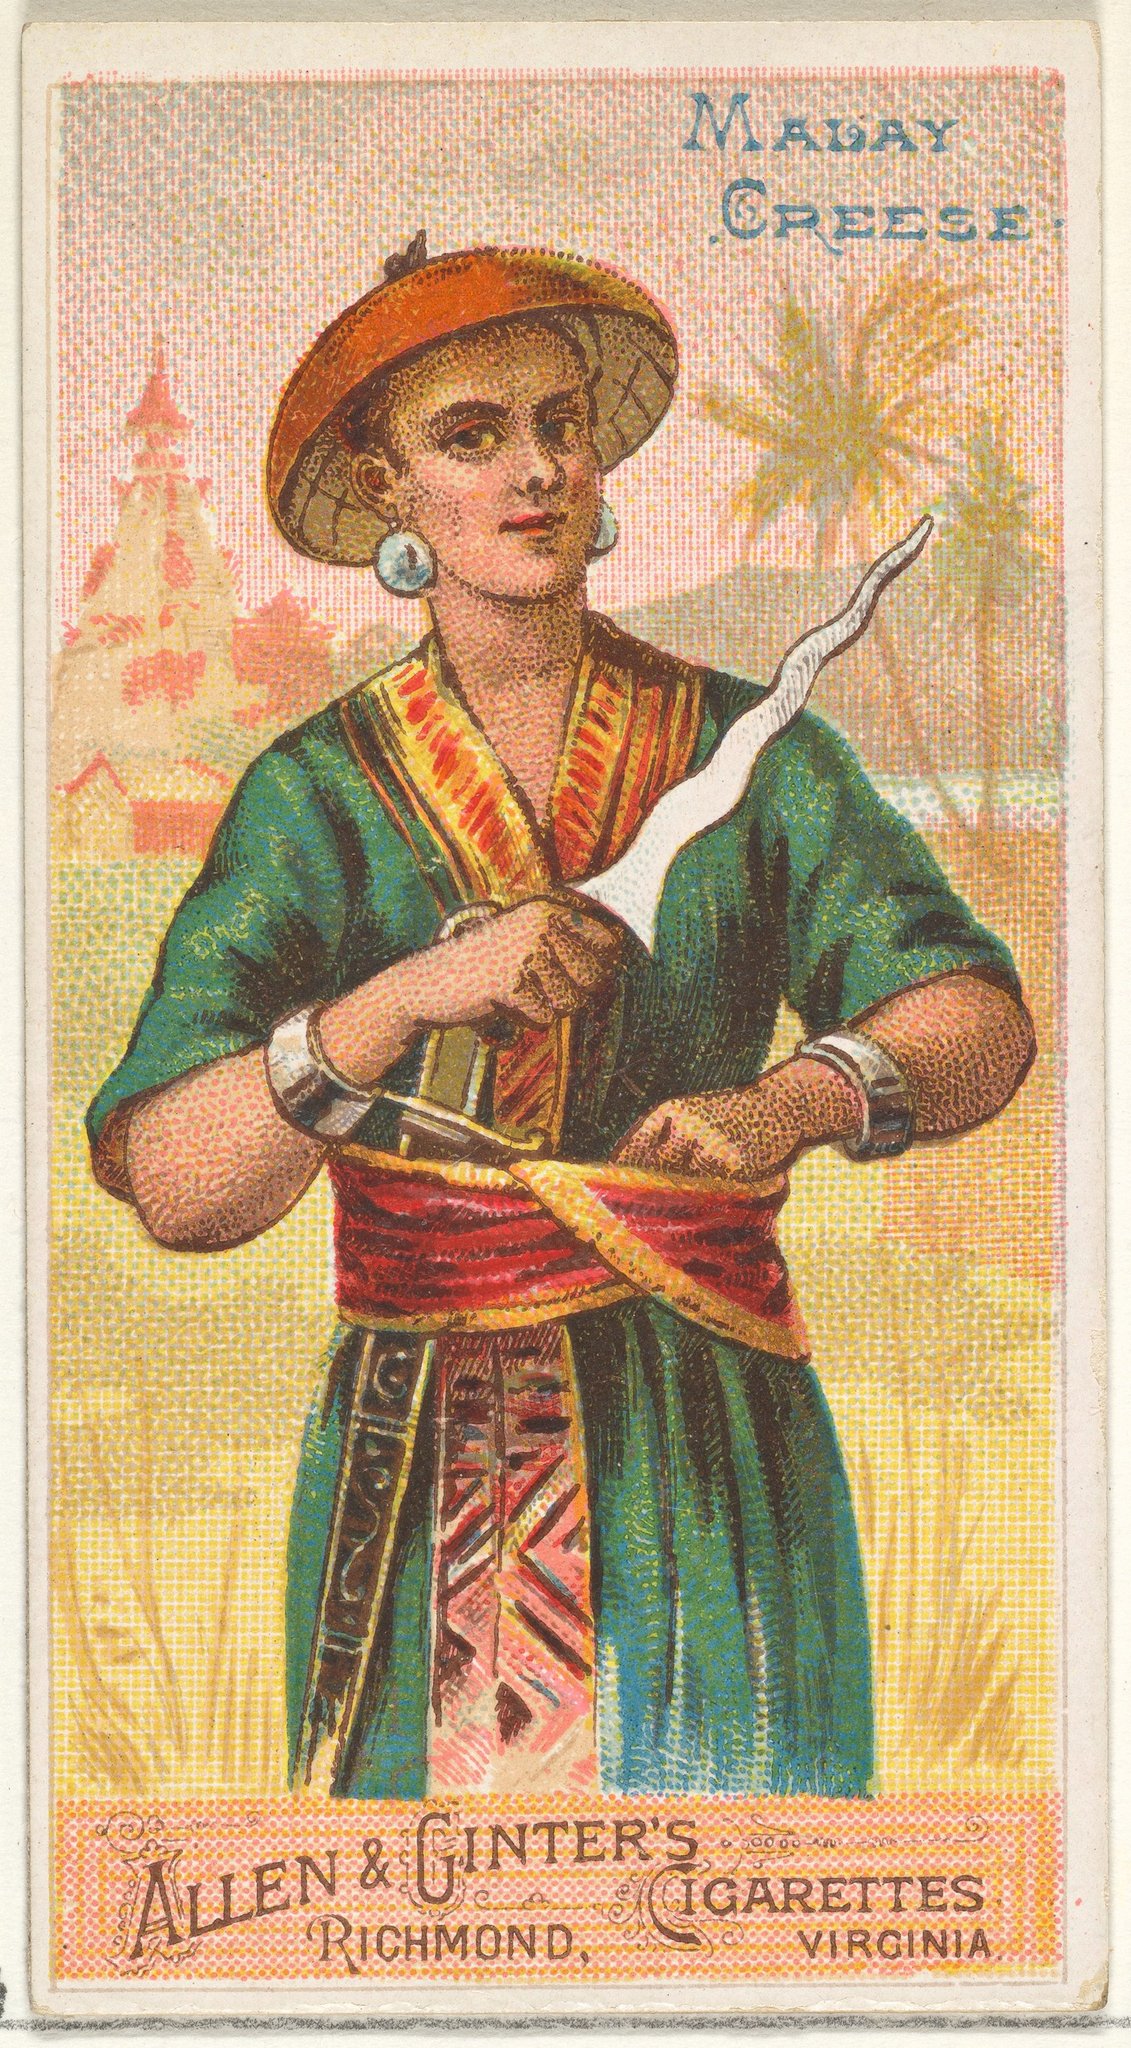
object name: print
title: Malay Creese, from the Arms of All Nations series (N3) for Allen & Ginter Cigarettes Brands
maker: allen & ginter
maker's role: publisher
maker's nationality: american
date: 1887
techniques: color lithograph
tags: weapons,men